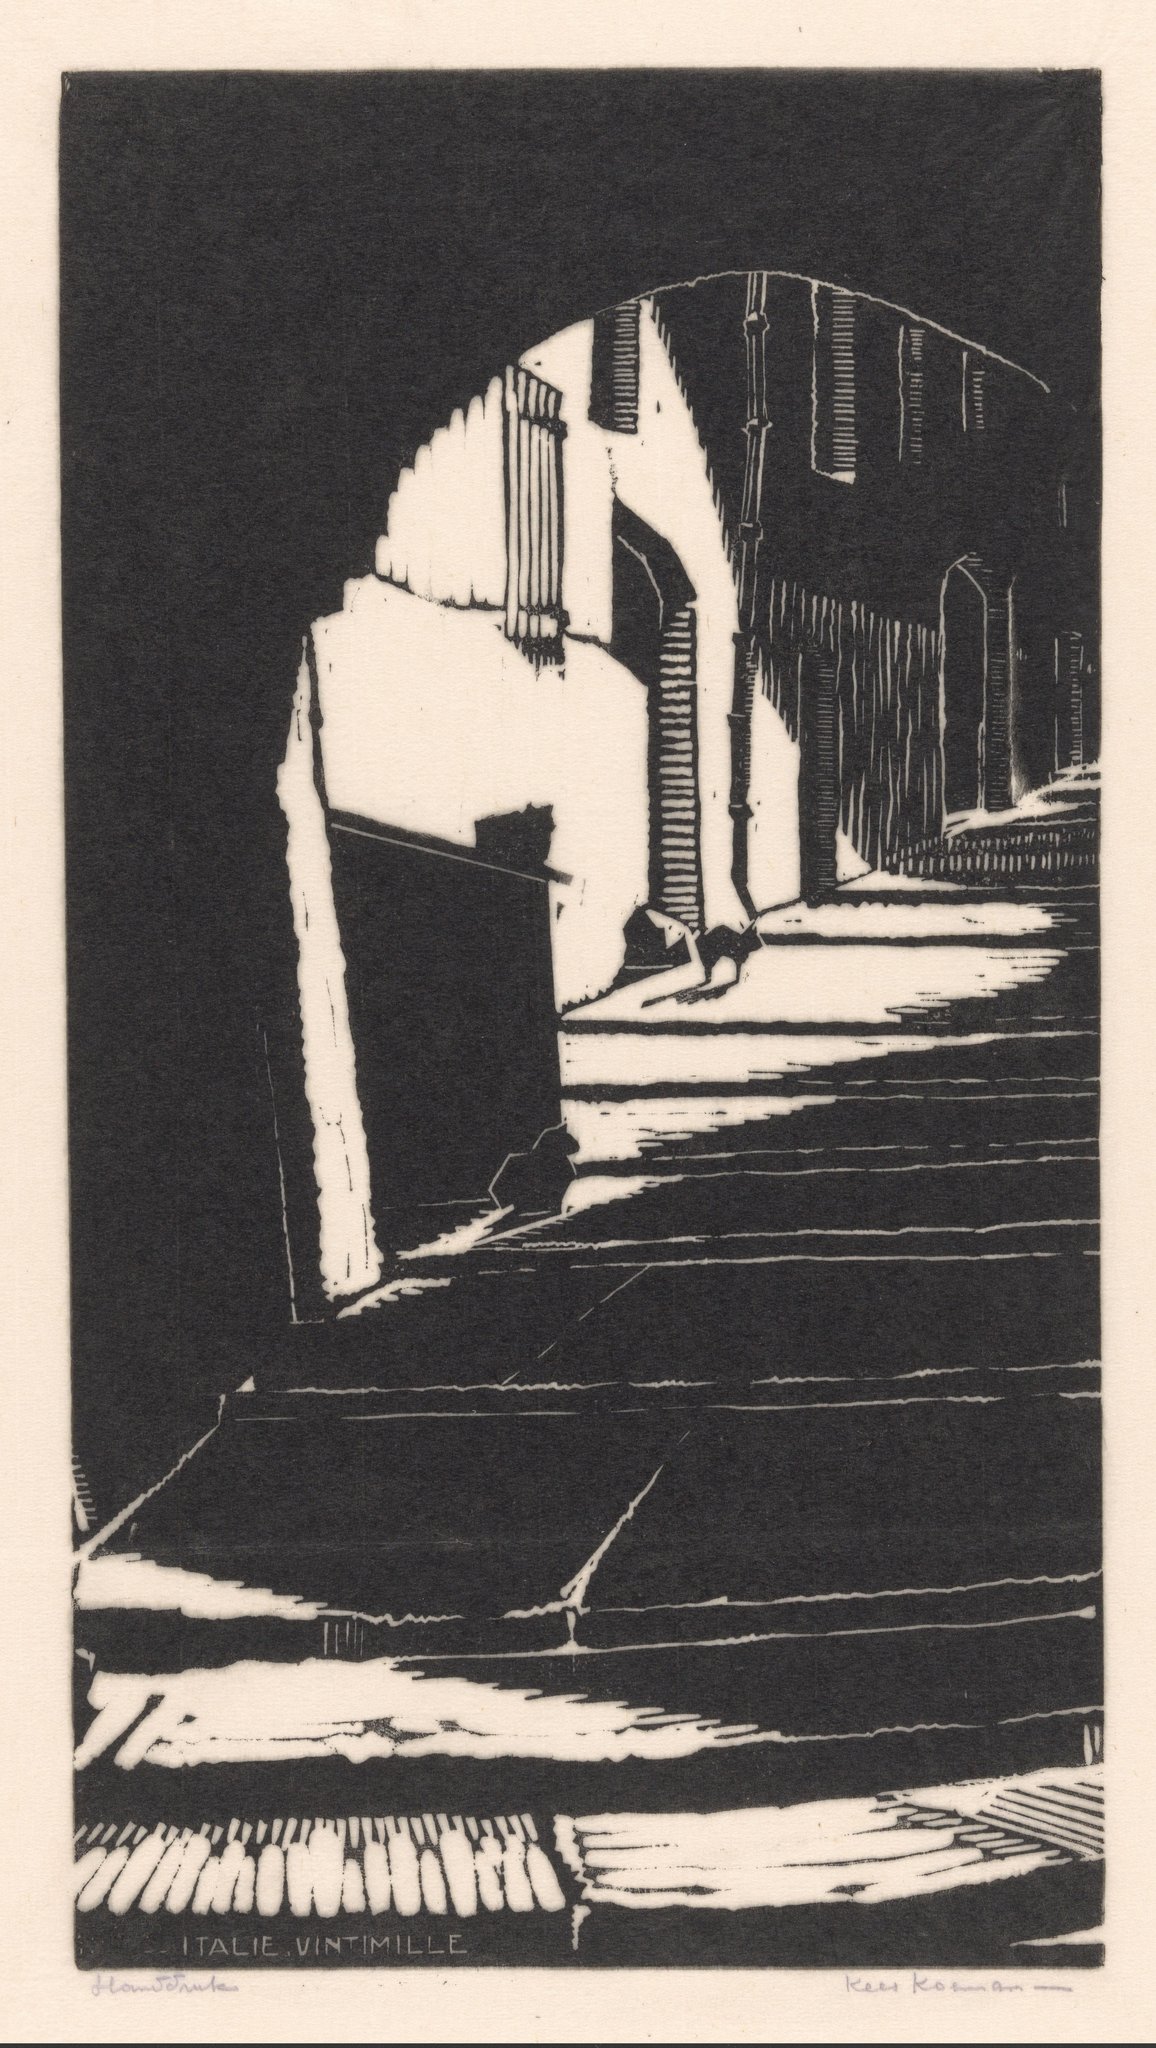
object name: print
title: Straatgezicht met drie katten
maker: kees koeman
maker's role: print maker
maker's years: 1895-1954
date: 1910-1932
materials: paper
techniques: woodcut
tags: cat, street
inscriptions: collector's mark: Lugt 2228